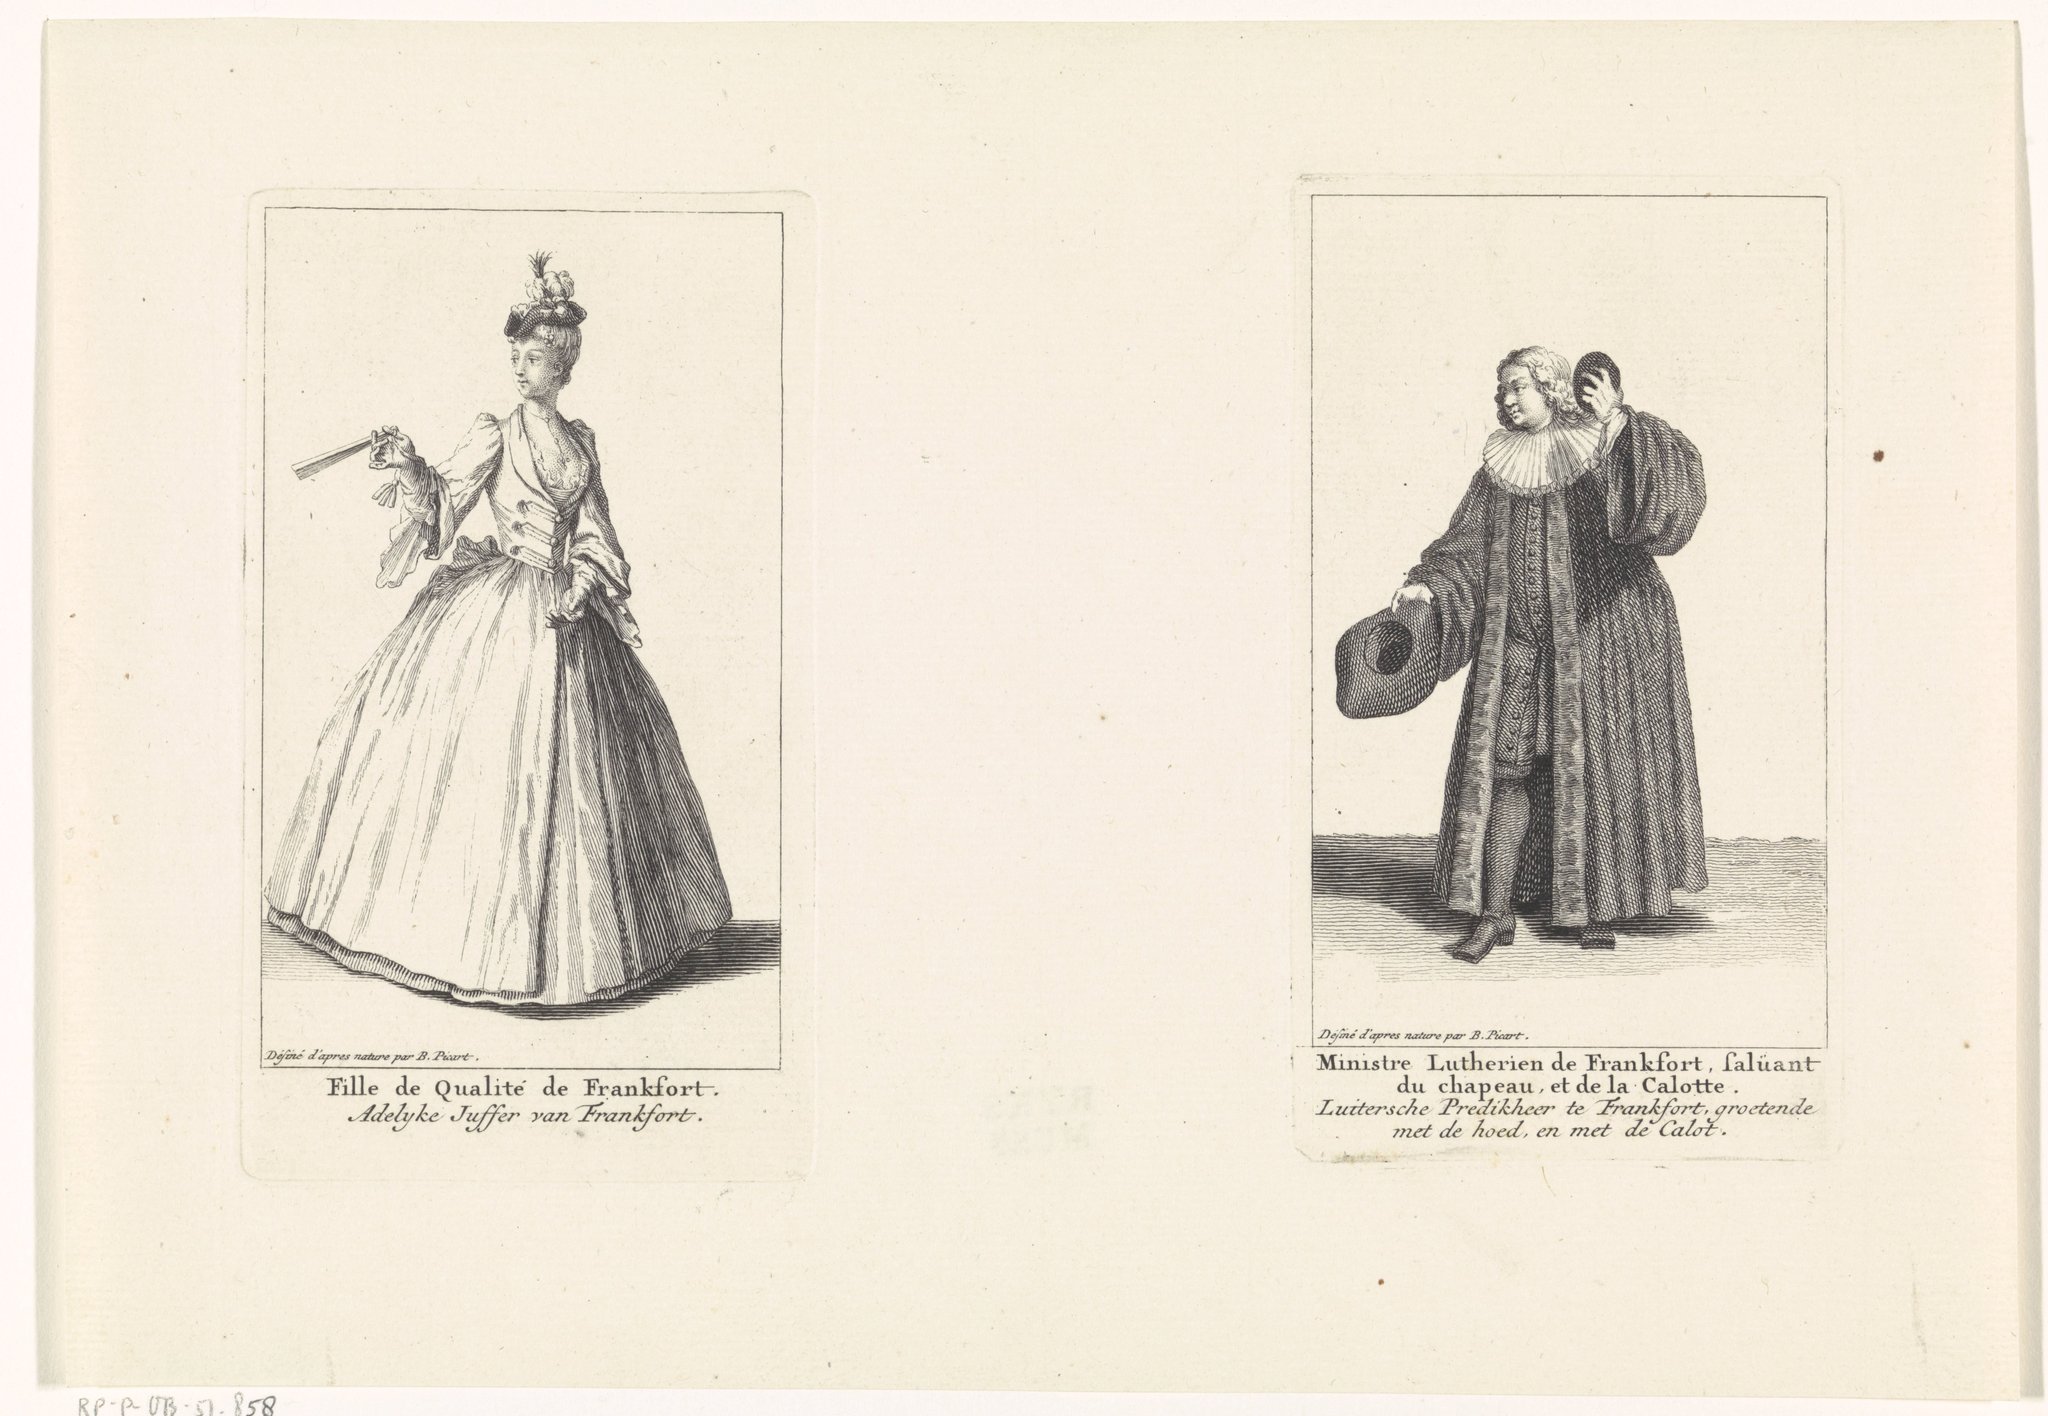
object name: costume print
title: Adellijke dame en Lutherse dominee uit Frankfurt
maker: bernard picart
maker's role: draughtsman, print maker, publisher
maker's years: 1673-1733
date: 1728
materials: paper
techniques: engraving, etching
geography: amsterdam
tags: folk costume, regional costume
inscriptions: collector's mark: Lugt 2165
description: Niet versneden blad met twee prenten met voorstellingen van figuren in klederdracht. Een dame van stand uit Frankfurt, gekleed volgens de mode van ca. 1728. Een Lutherse dominee uit Frankfurt, gekleed in lange mantel waaroverheen een brede geplooide kraag. De prenten hebben een titel in het Frans en in het Nederlands.